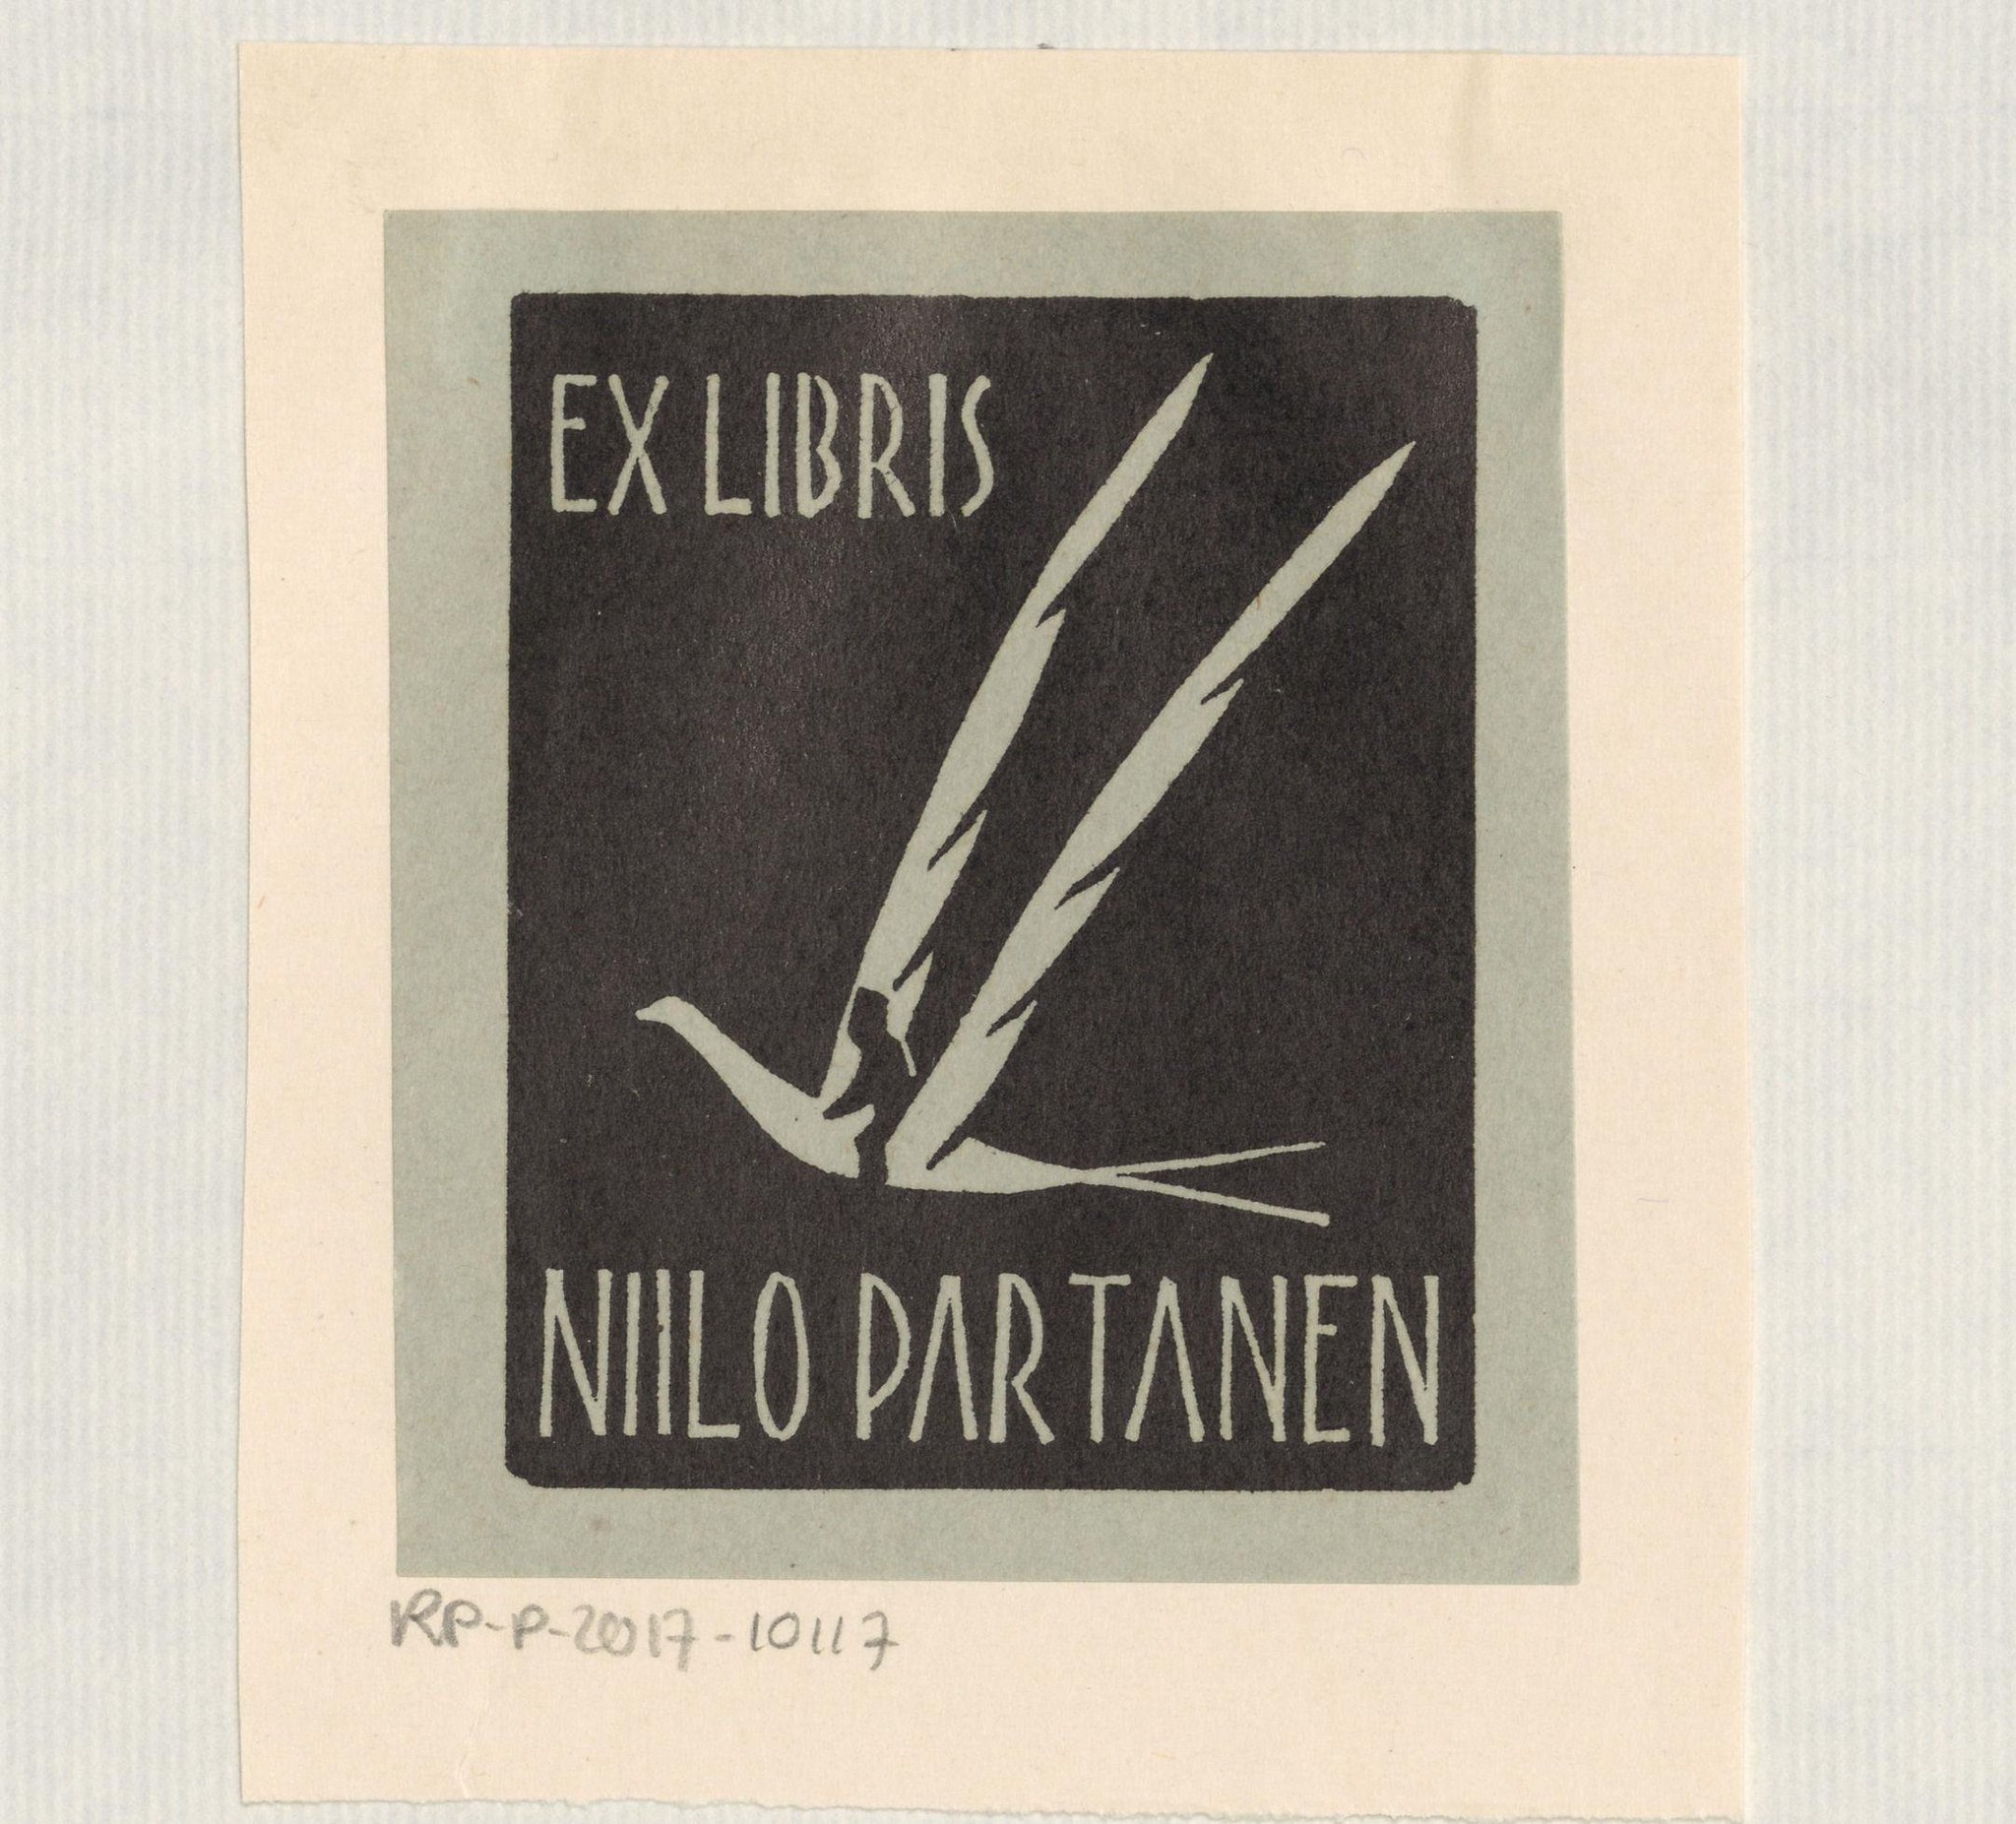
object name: bookplate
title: Ex libris van Niilo Partanen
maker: pekka törmä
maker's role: print maker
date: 1942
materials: paper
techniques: linocut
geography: finland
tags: flying on or with the aid of animal(s), birds